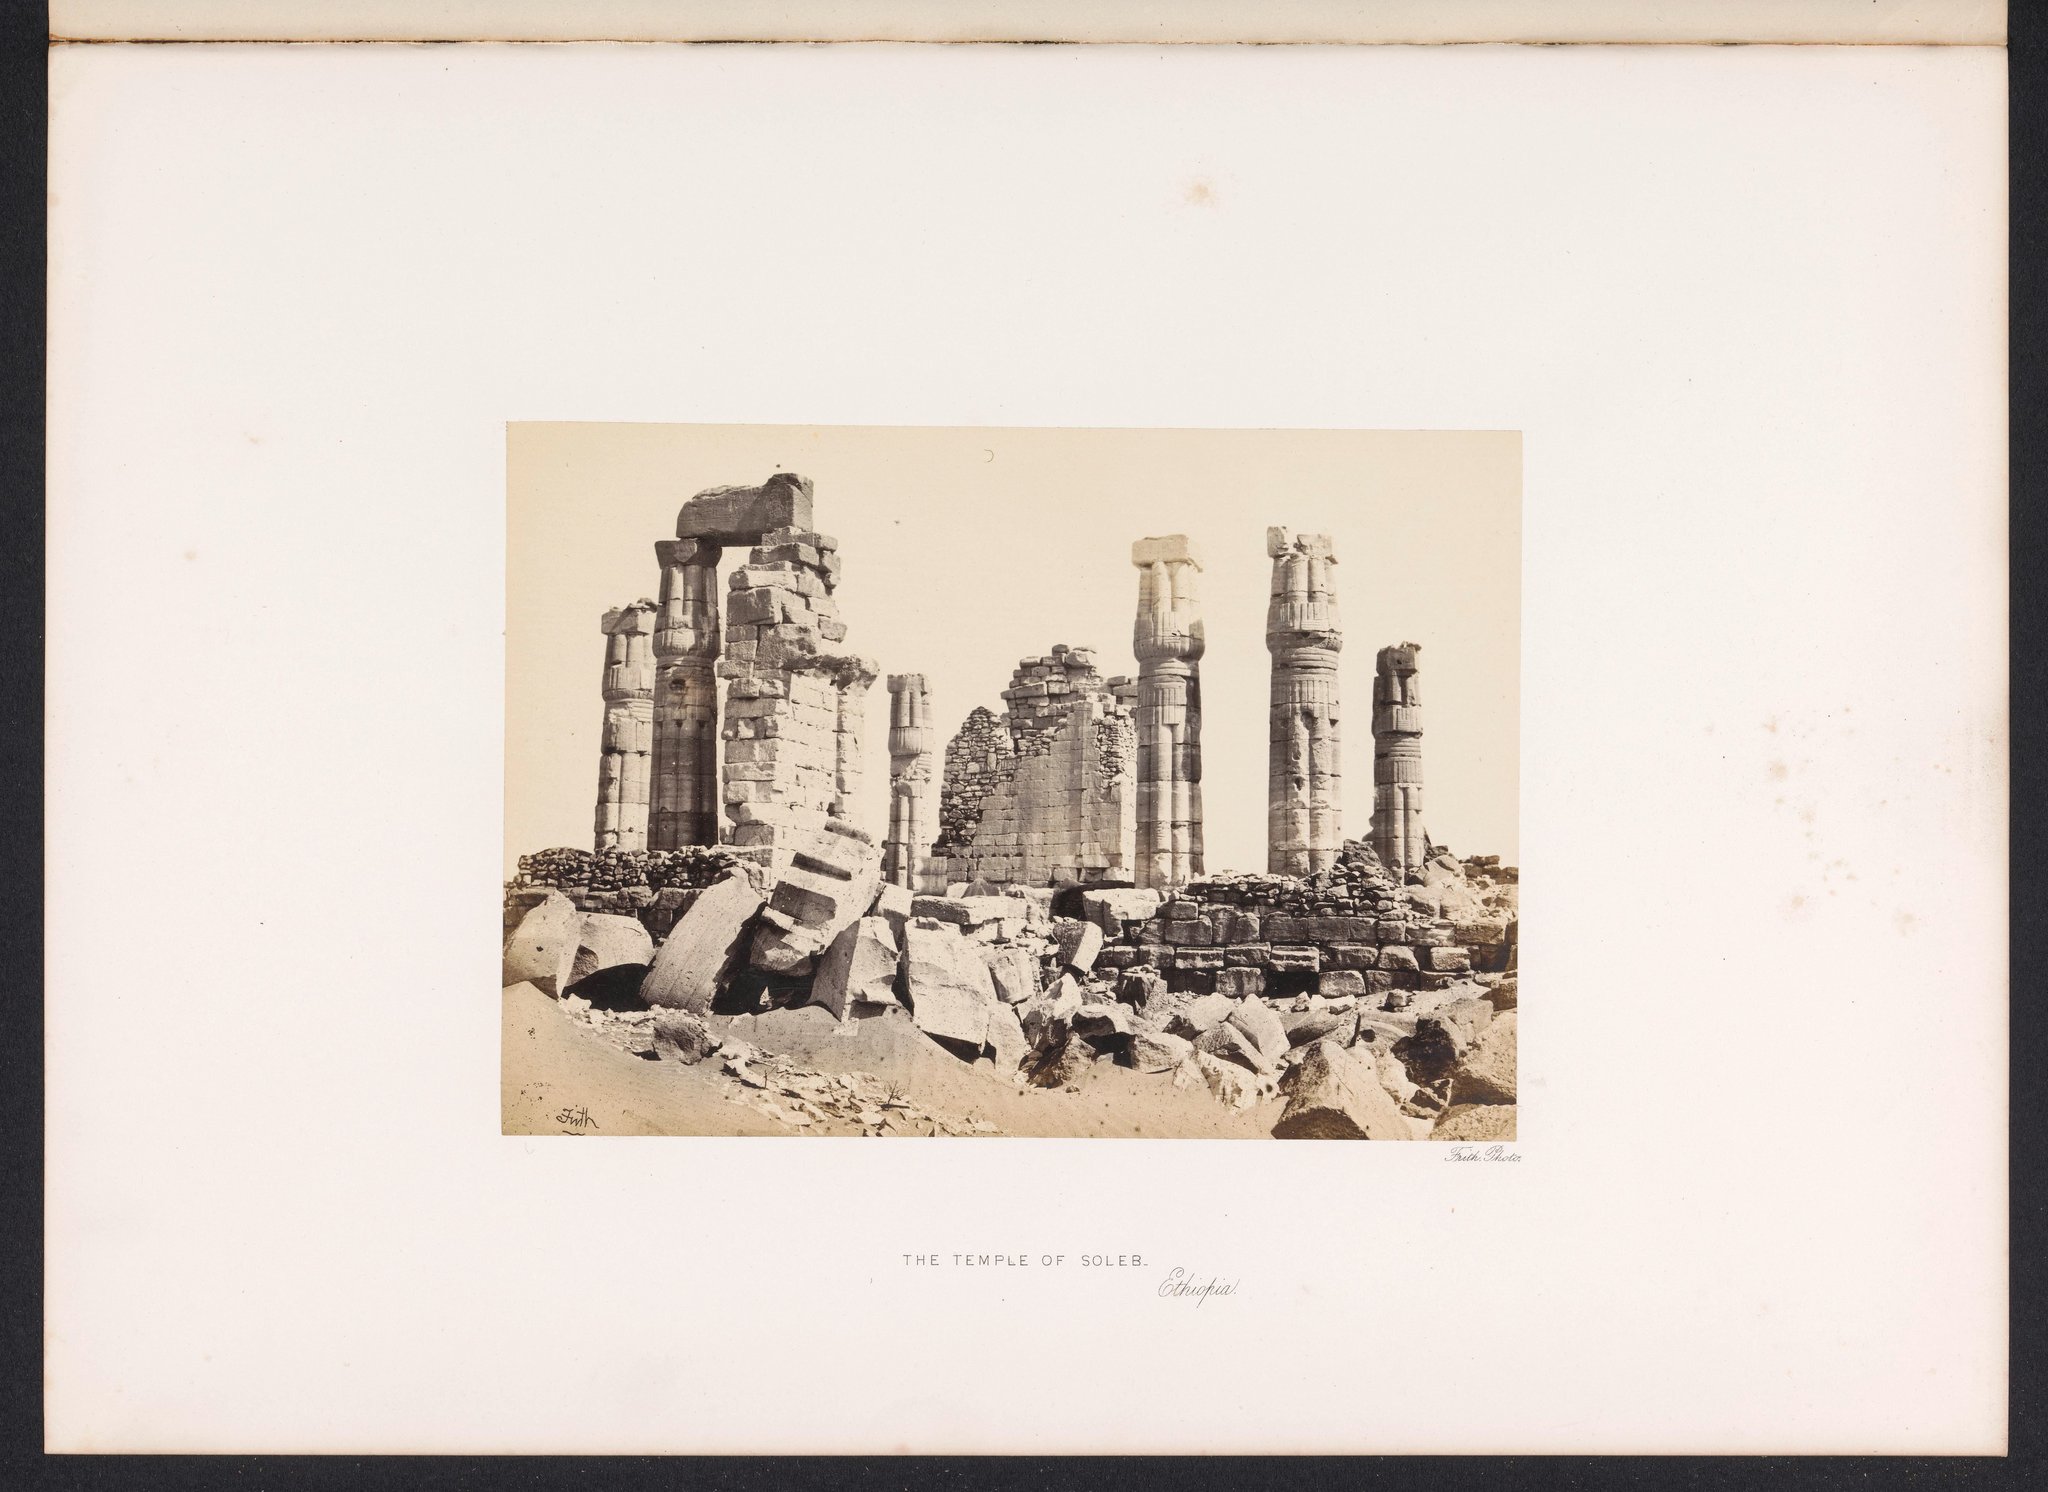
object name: page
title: The temple of Soleb - Ethiopia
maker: francis frith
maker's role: publisher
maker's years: 1822-1898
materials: paper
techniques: albumen print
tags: ruin of a building ~ architecture